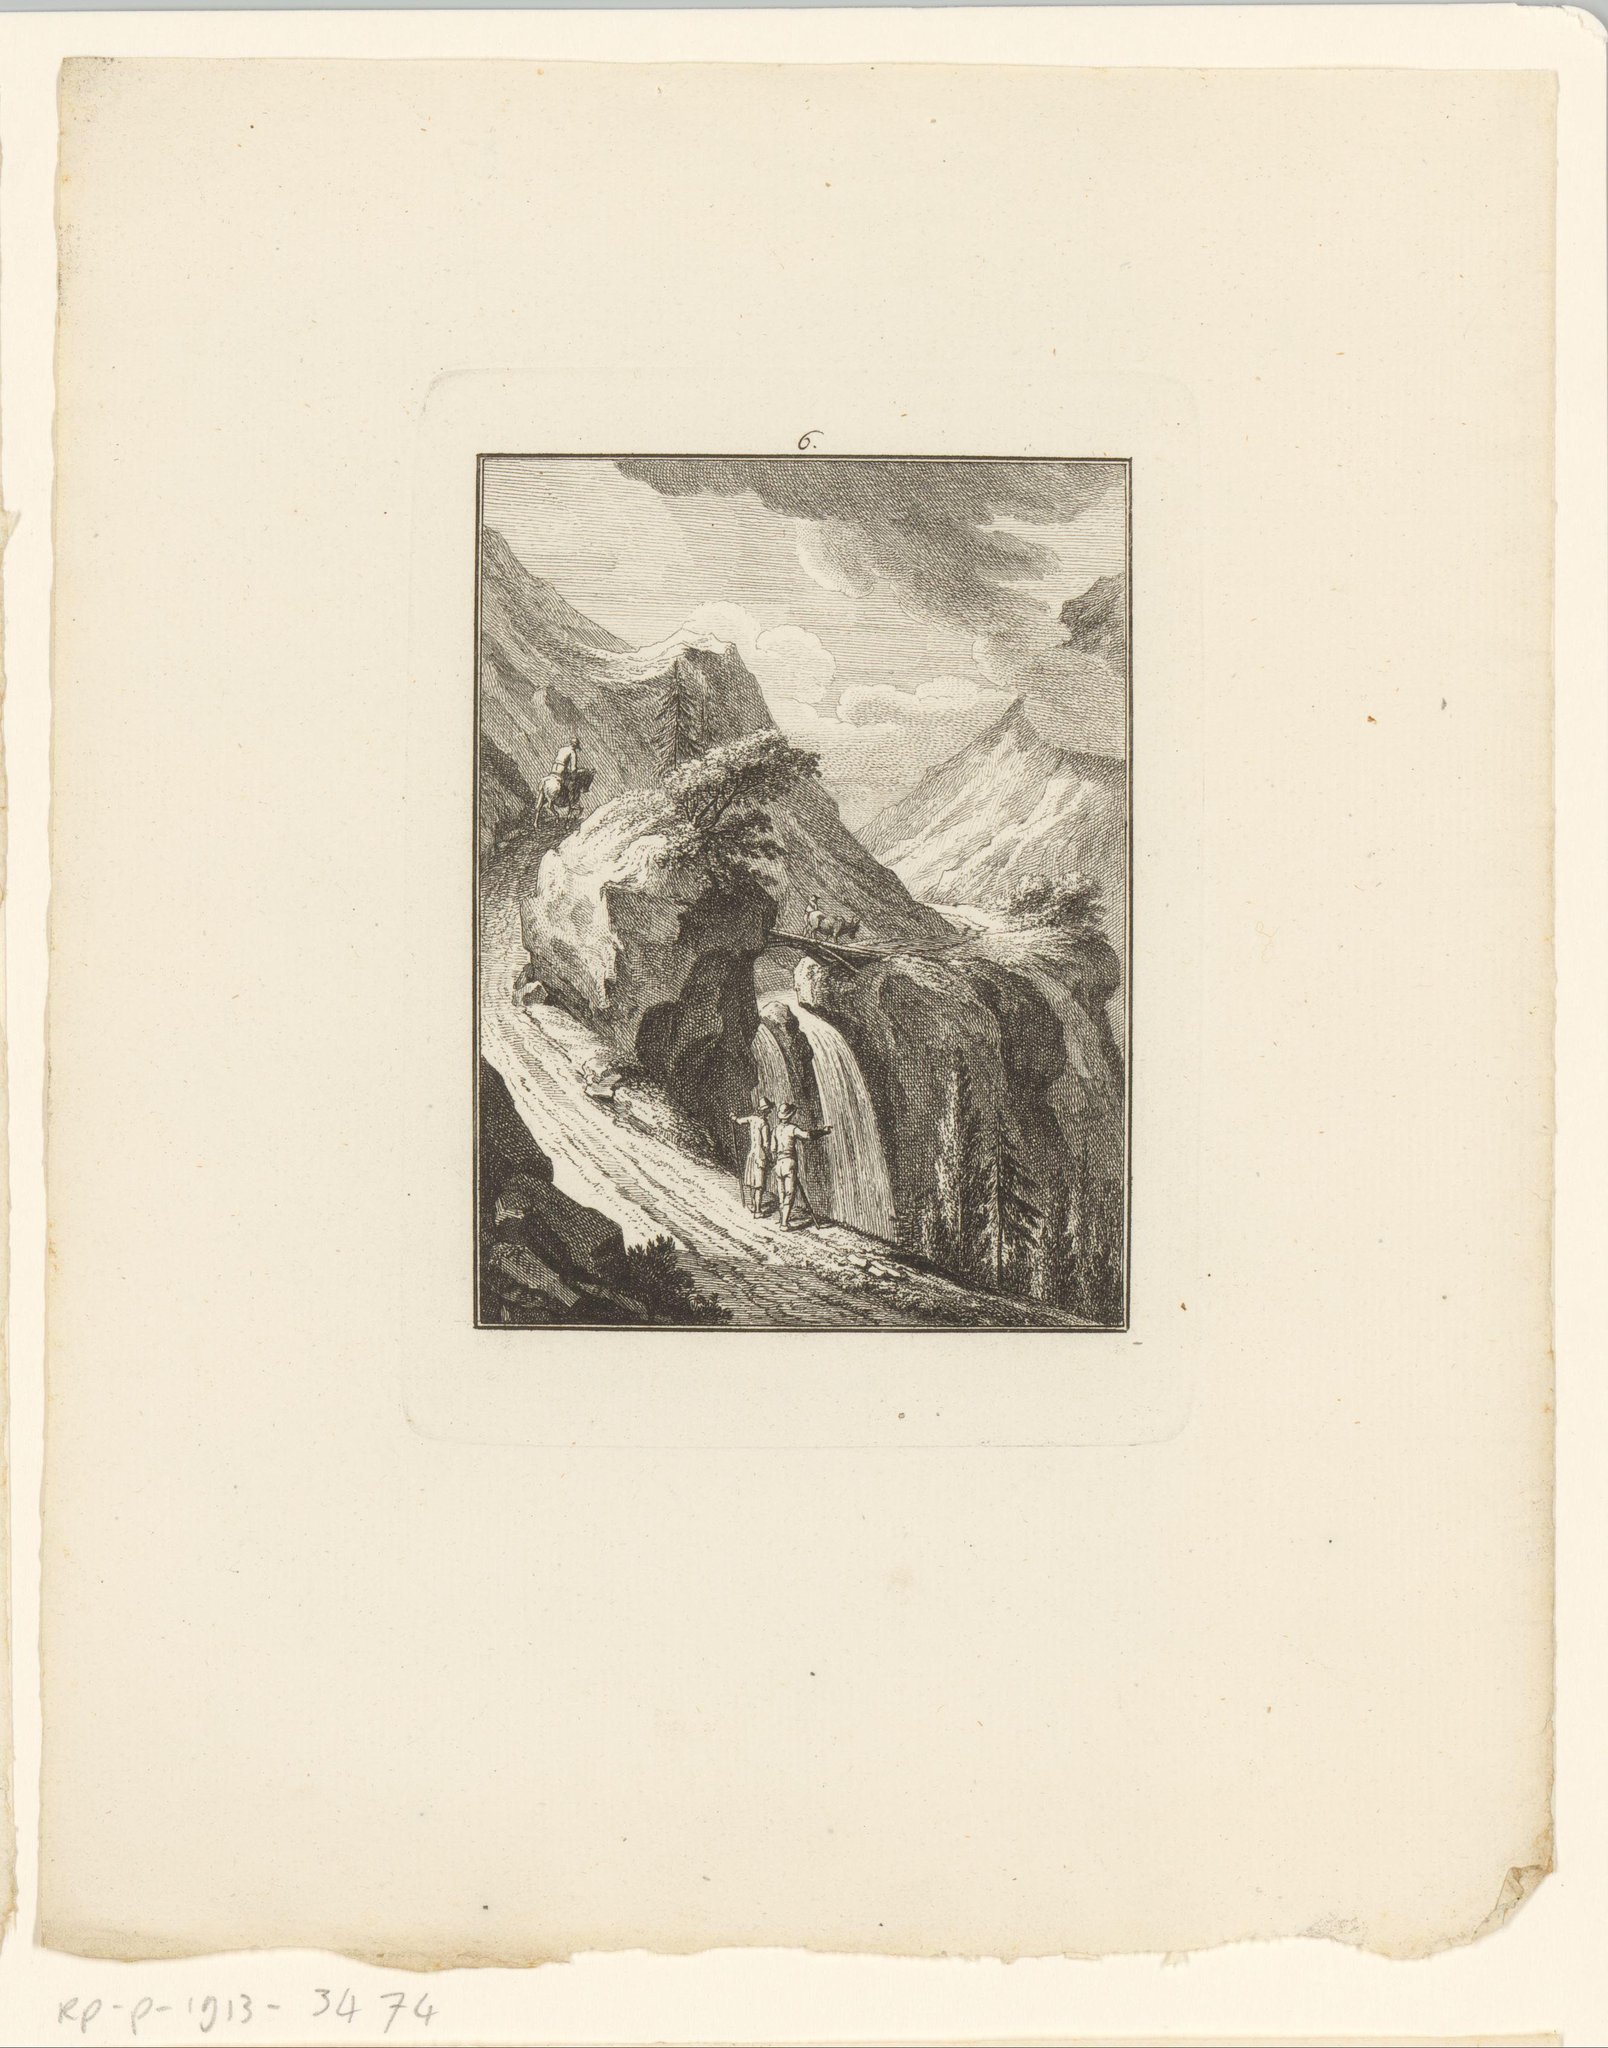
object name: print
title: Landschappen met water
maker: johann rudolph schellenberg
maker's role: print maker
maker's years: 1740-1806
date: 1781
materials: paper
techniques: etching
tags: waterfall, landscapes with waters, waterscapes, seascapes (in the temperate zone), 'en route', traveller under way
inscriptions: collector's mark: Lugt 2228